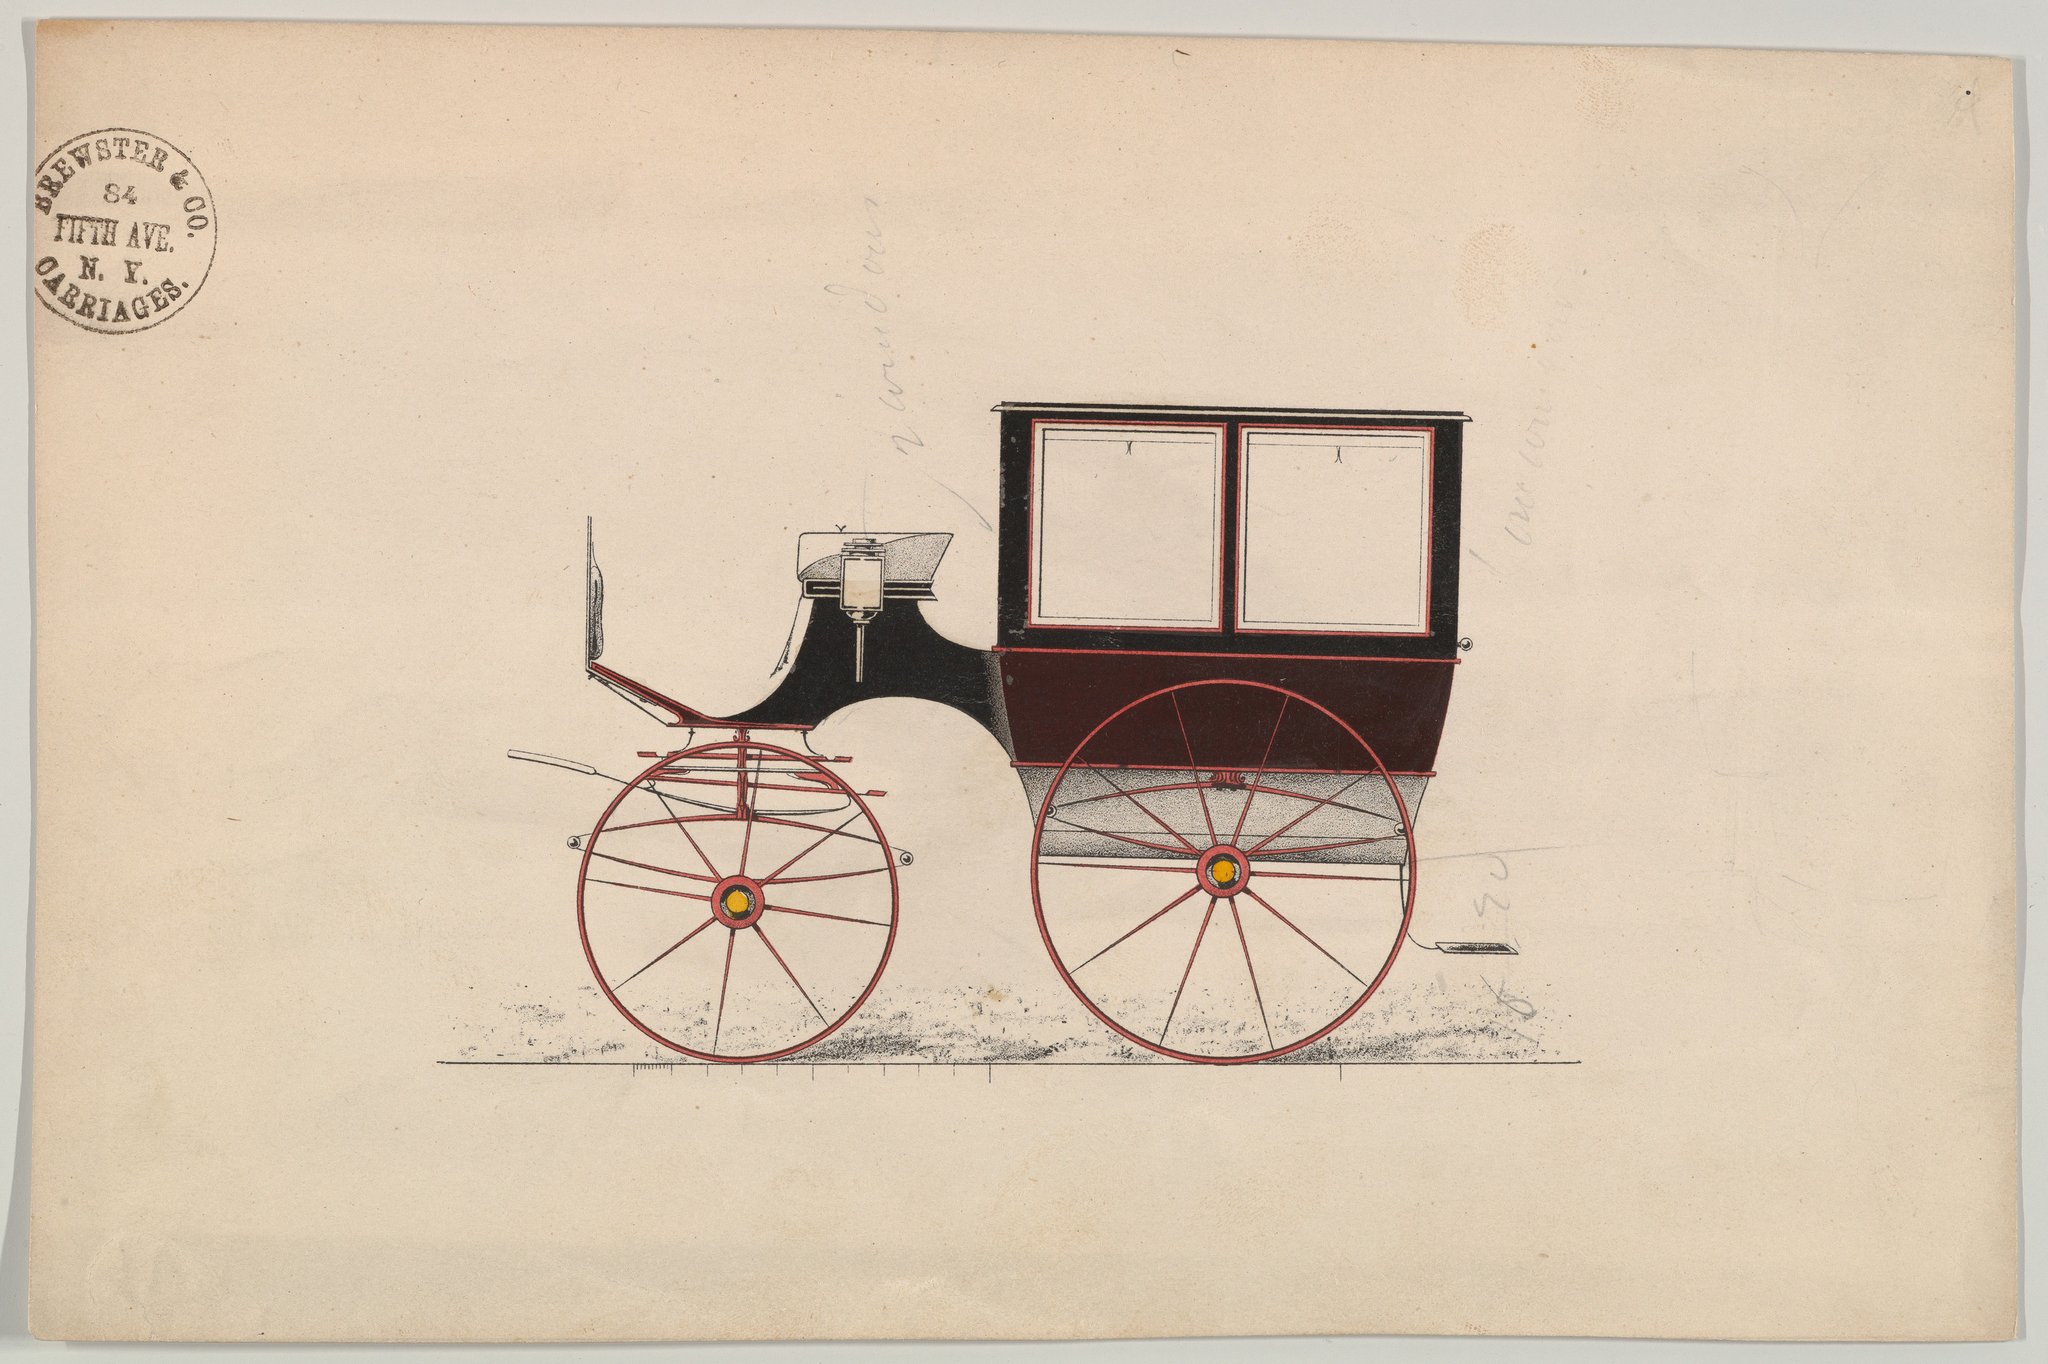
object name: print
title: Design for Wagonette or Omnibus (unnumbered)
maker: brewster & co.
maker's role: manufacturer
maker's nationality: american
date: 1850-1870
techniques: hand coloring, lithograph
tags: carriages